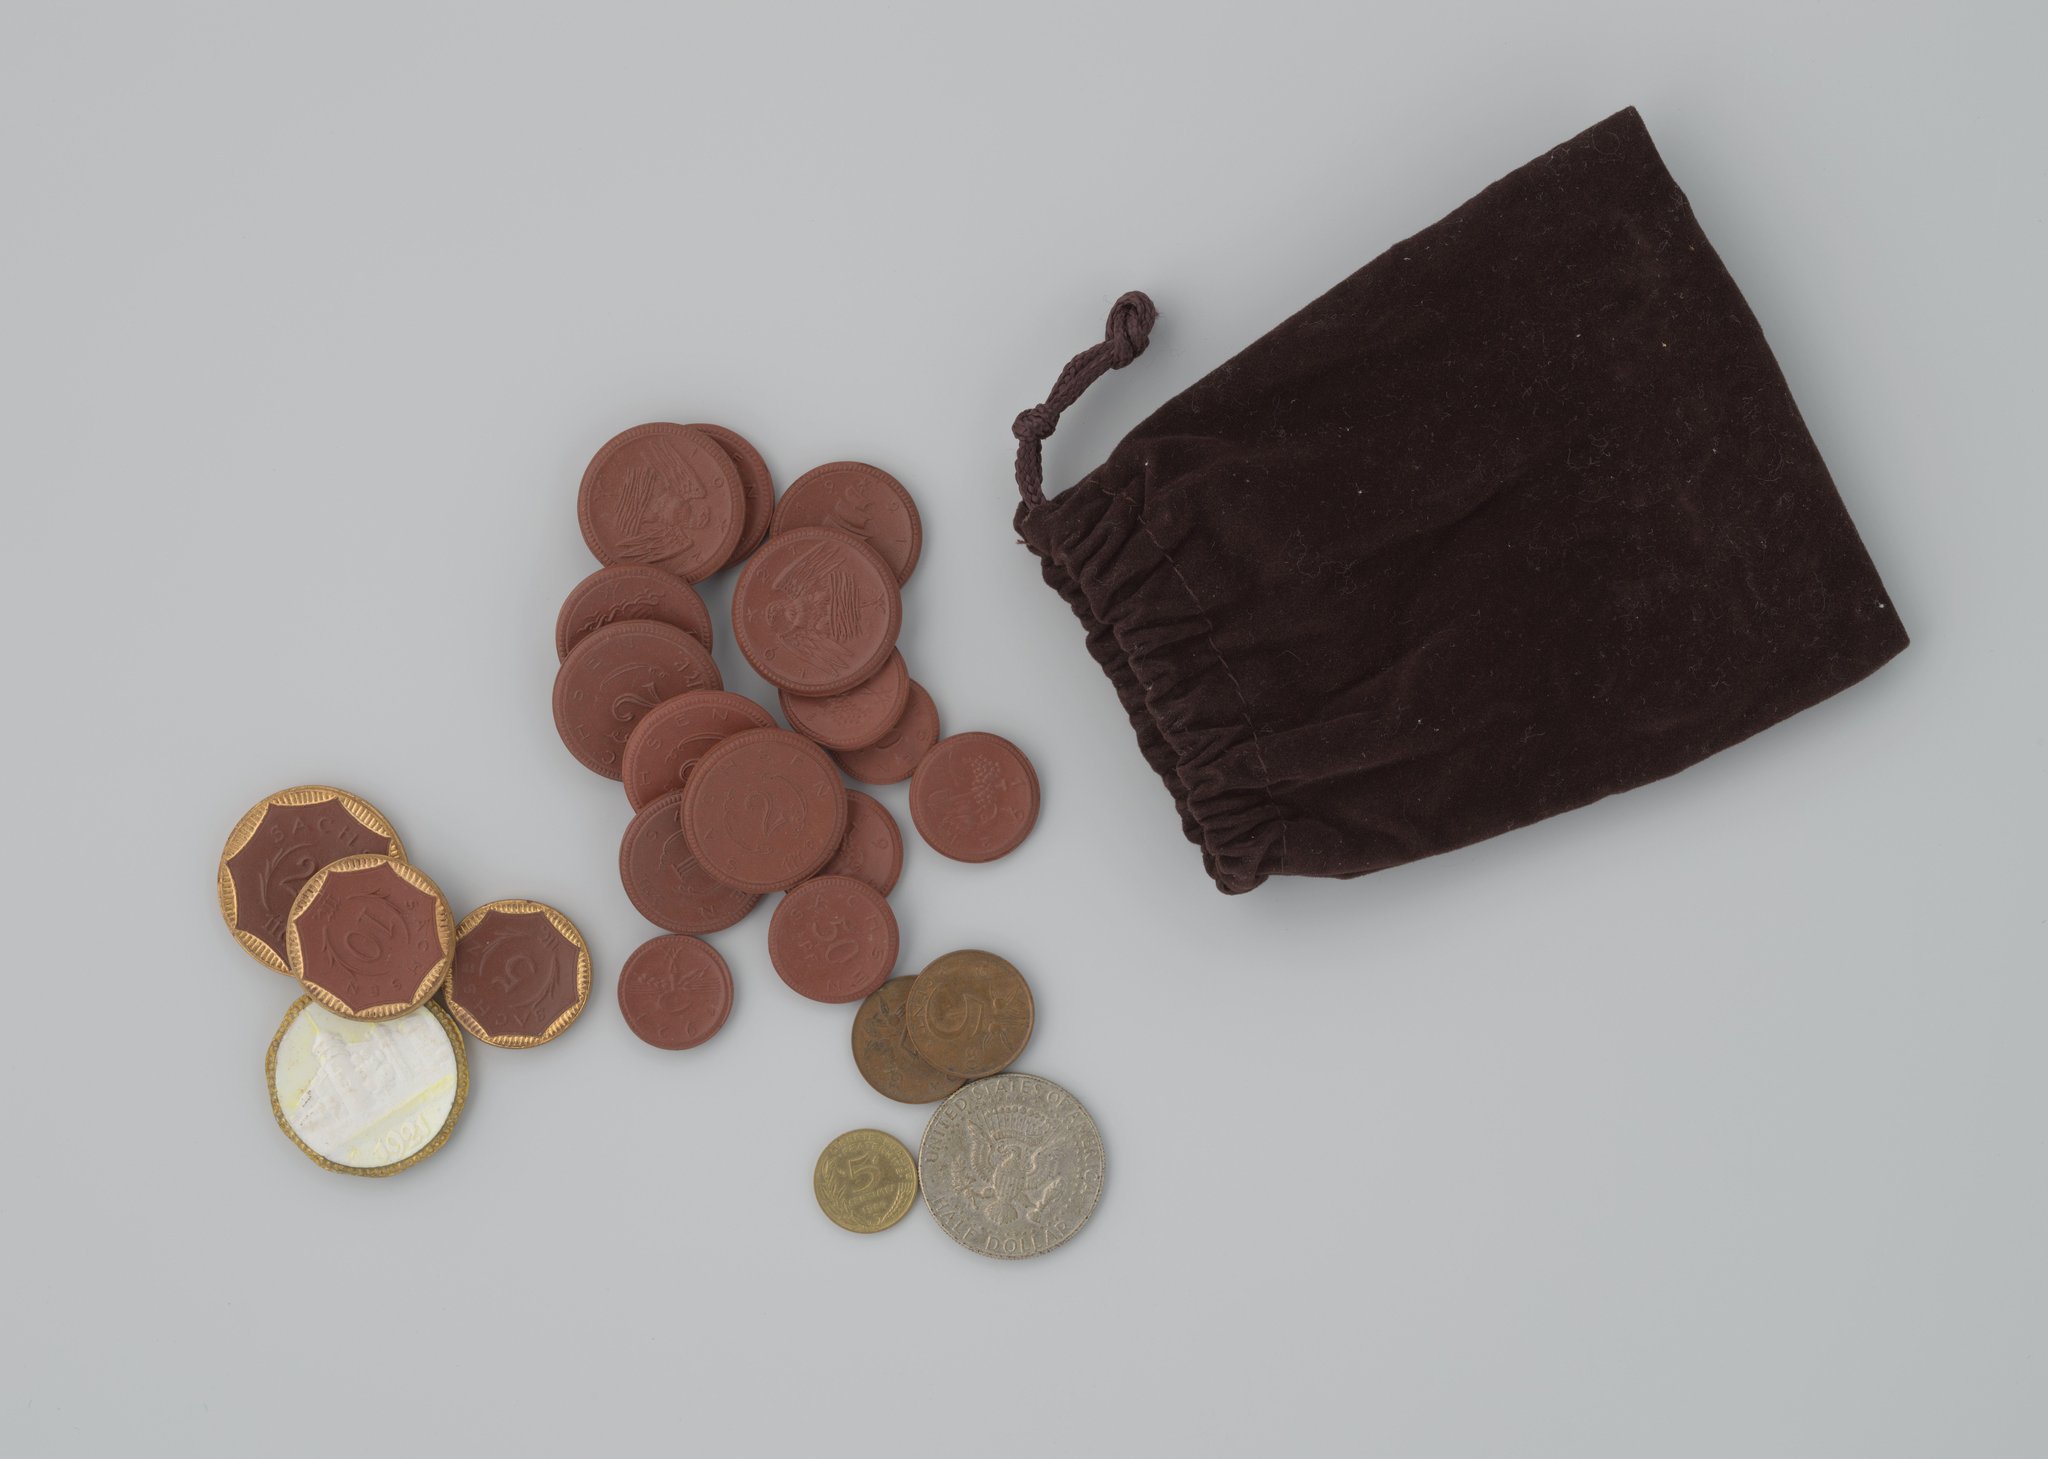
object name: coin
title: Foedraal van bruin fluweel, bevattend 24 (nood)munten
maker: Anonymous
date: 1900-1925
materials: velvet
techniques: sewing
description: Dit object is onderdeel van de nalatenschap van Isabel Elon-Wachenheimer (1928-2010). Tot haar overlijden behoorde het samen met de andere objecten uit de nalatenschap tot haar privédomein van Isabel Wachenheimer. In die particuliere context zijn deze objecten tezamen en individueel aandenkens - aan de jeugd, ouders en familie van Isabel Wachenheimer vóór en tijdens de Shoah en aan haar leven na de Tweede Wereldoorlog. Isabel Wachenheimer, die van juni 1943 tot mei 1945 gevangen zat in Kamp Westerbork, Theresienstadt, Auschwitz, Lenzing a/d Oberdonau (een buitenkamp van Mauthausen), overleefde de Shoah. Haar ouders – Eugène Wachenheimer en Else Wachenheimer-Moos - werden op 14 oktober 1944 in Auschwitz-Birkenau vermoord.